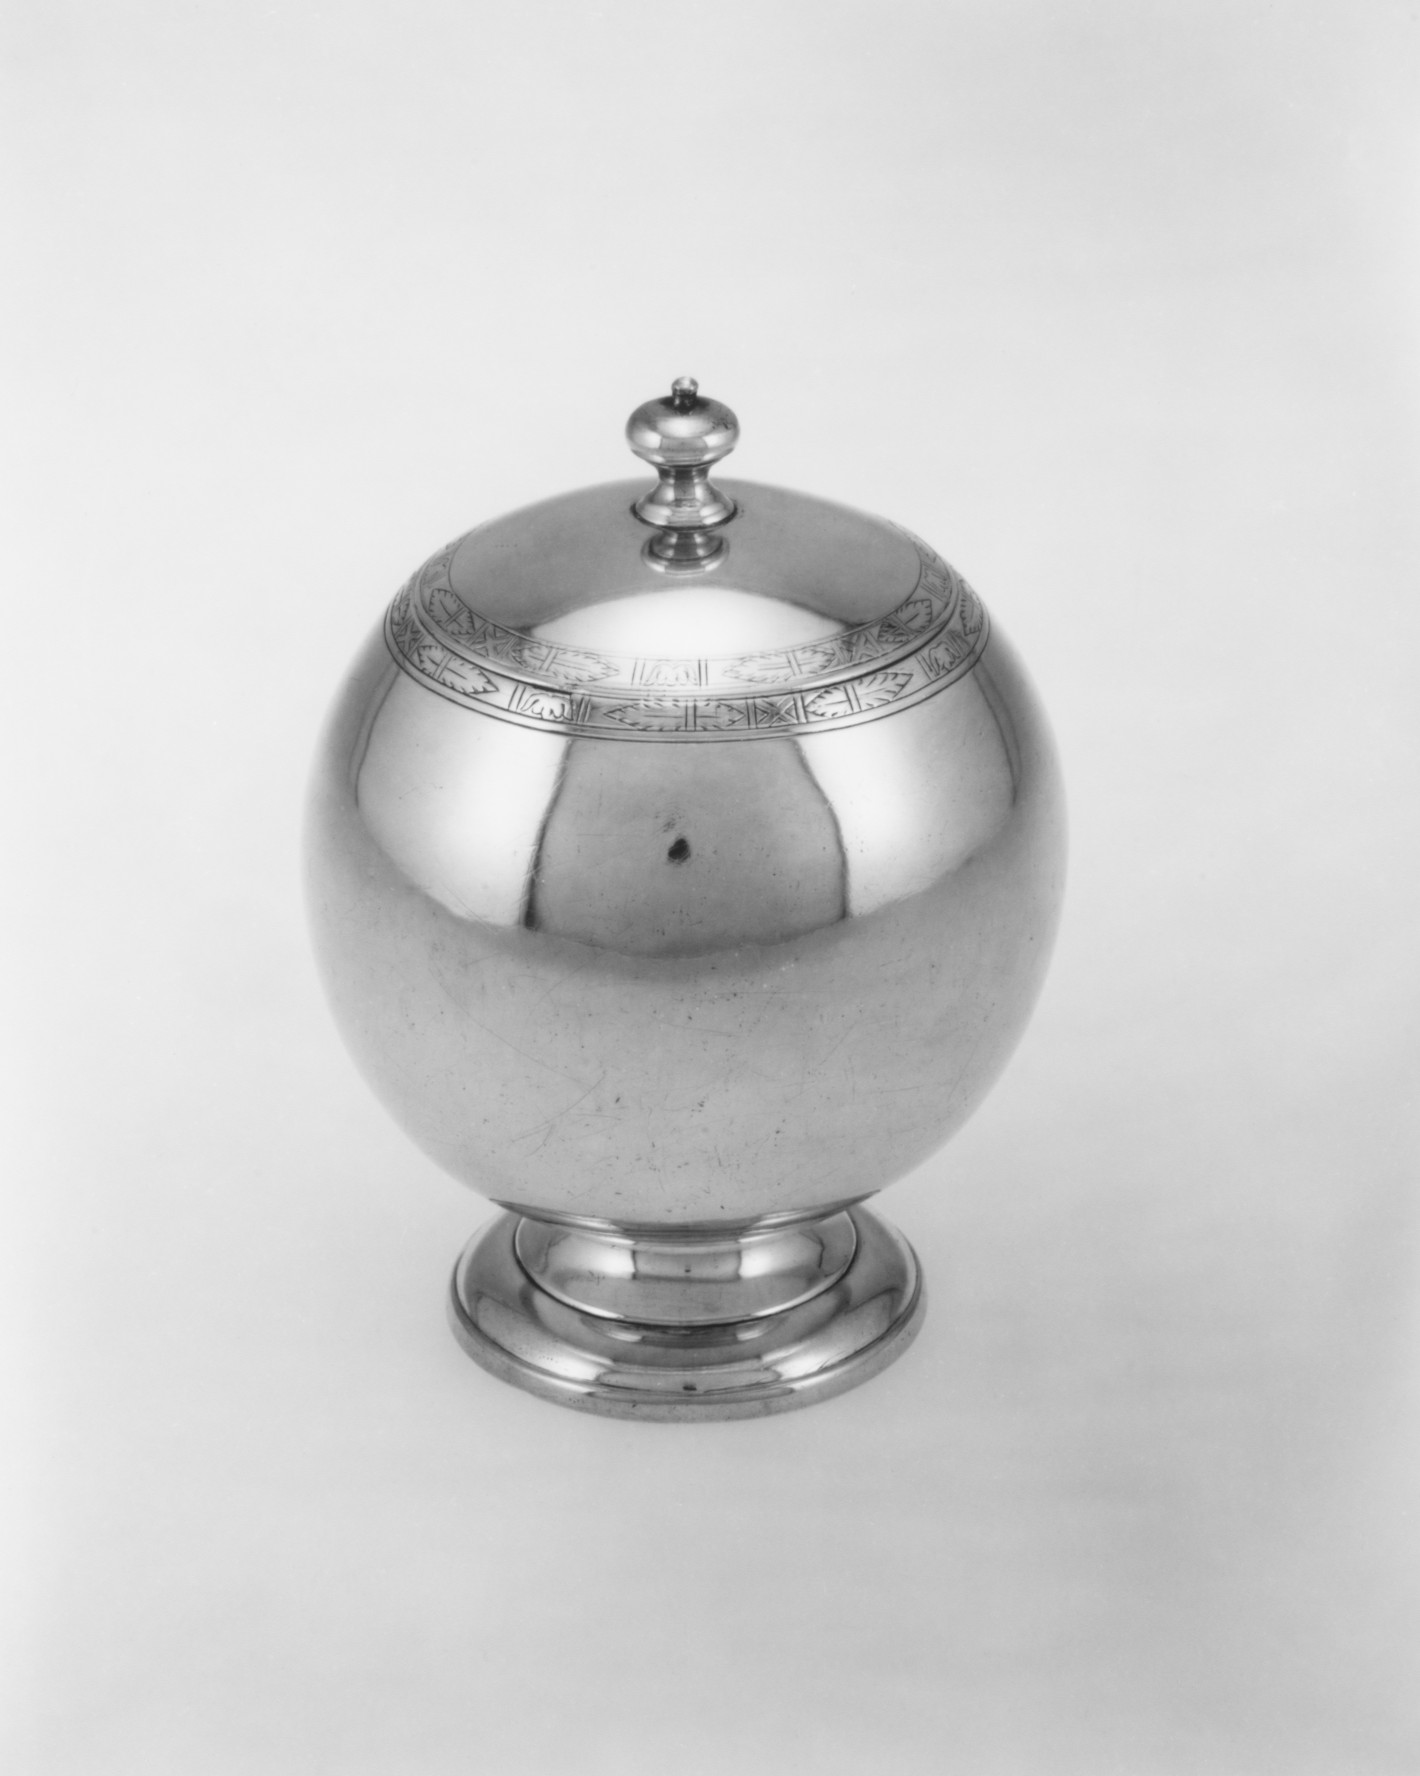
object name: sugar bowl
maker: james tait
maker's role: maker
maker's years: 1704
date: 1727-1728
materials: silver